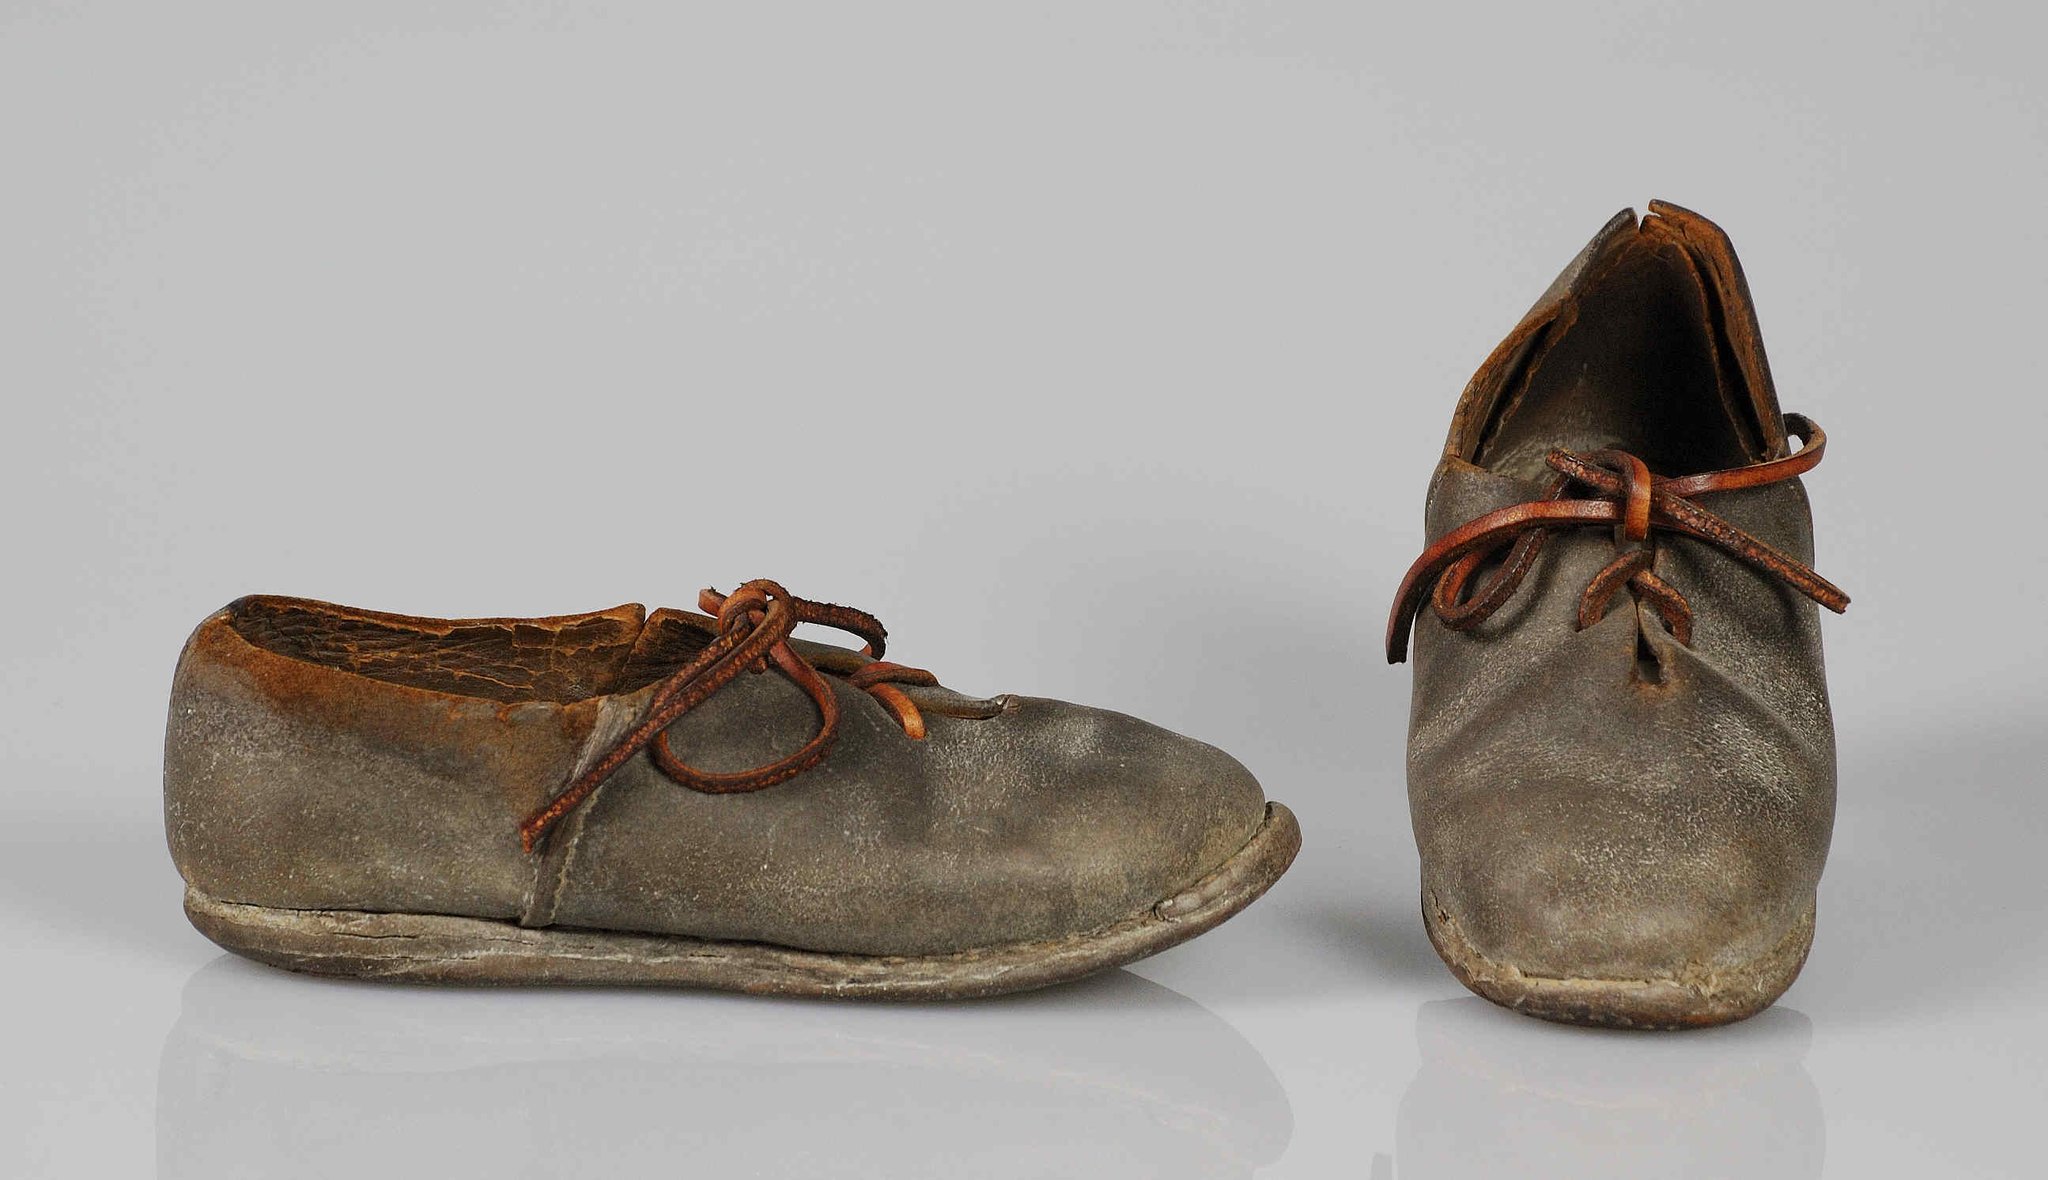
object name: shoe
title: Shoes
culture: american or european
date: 1775-1850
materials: leather